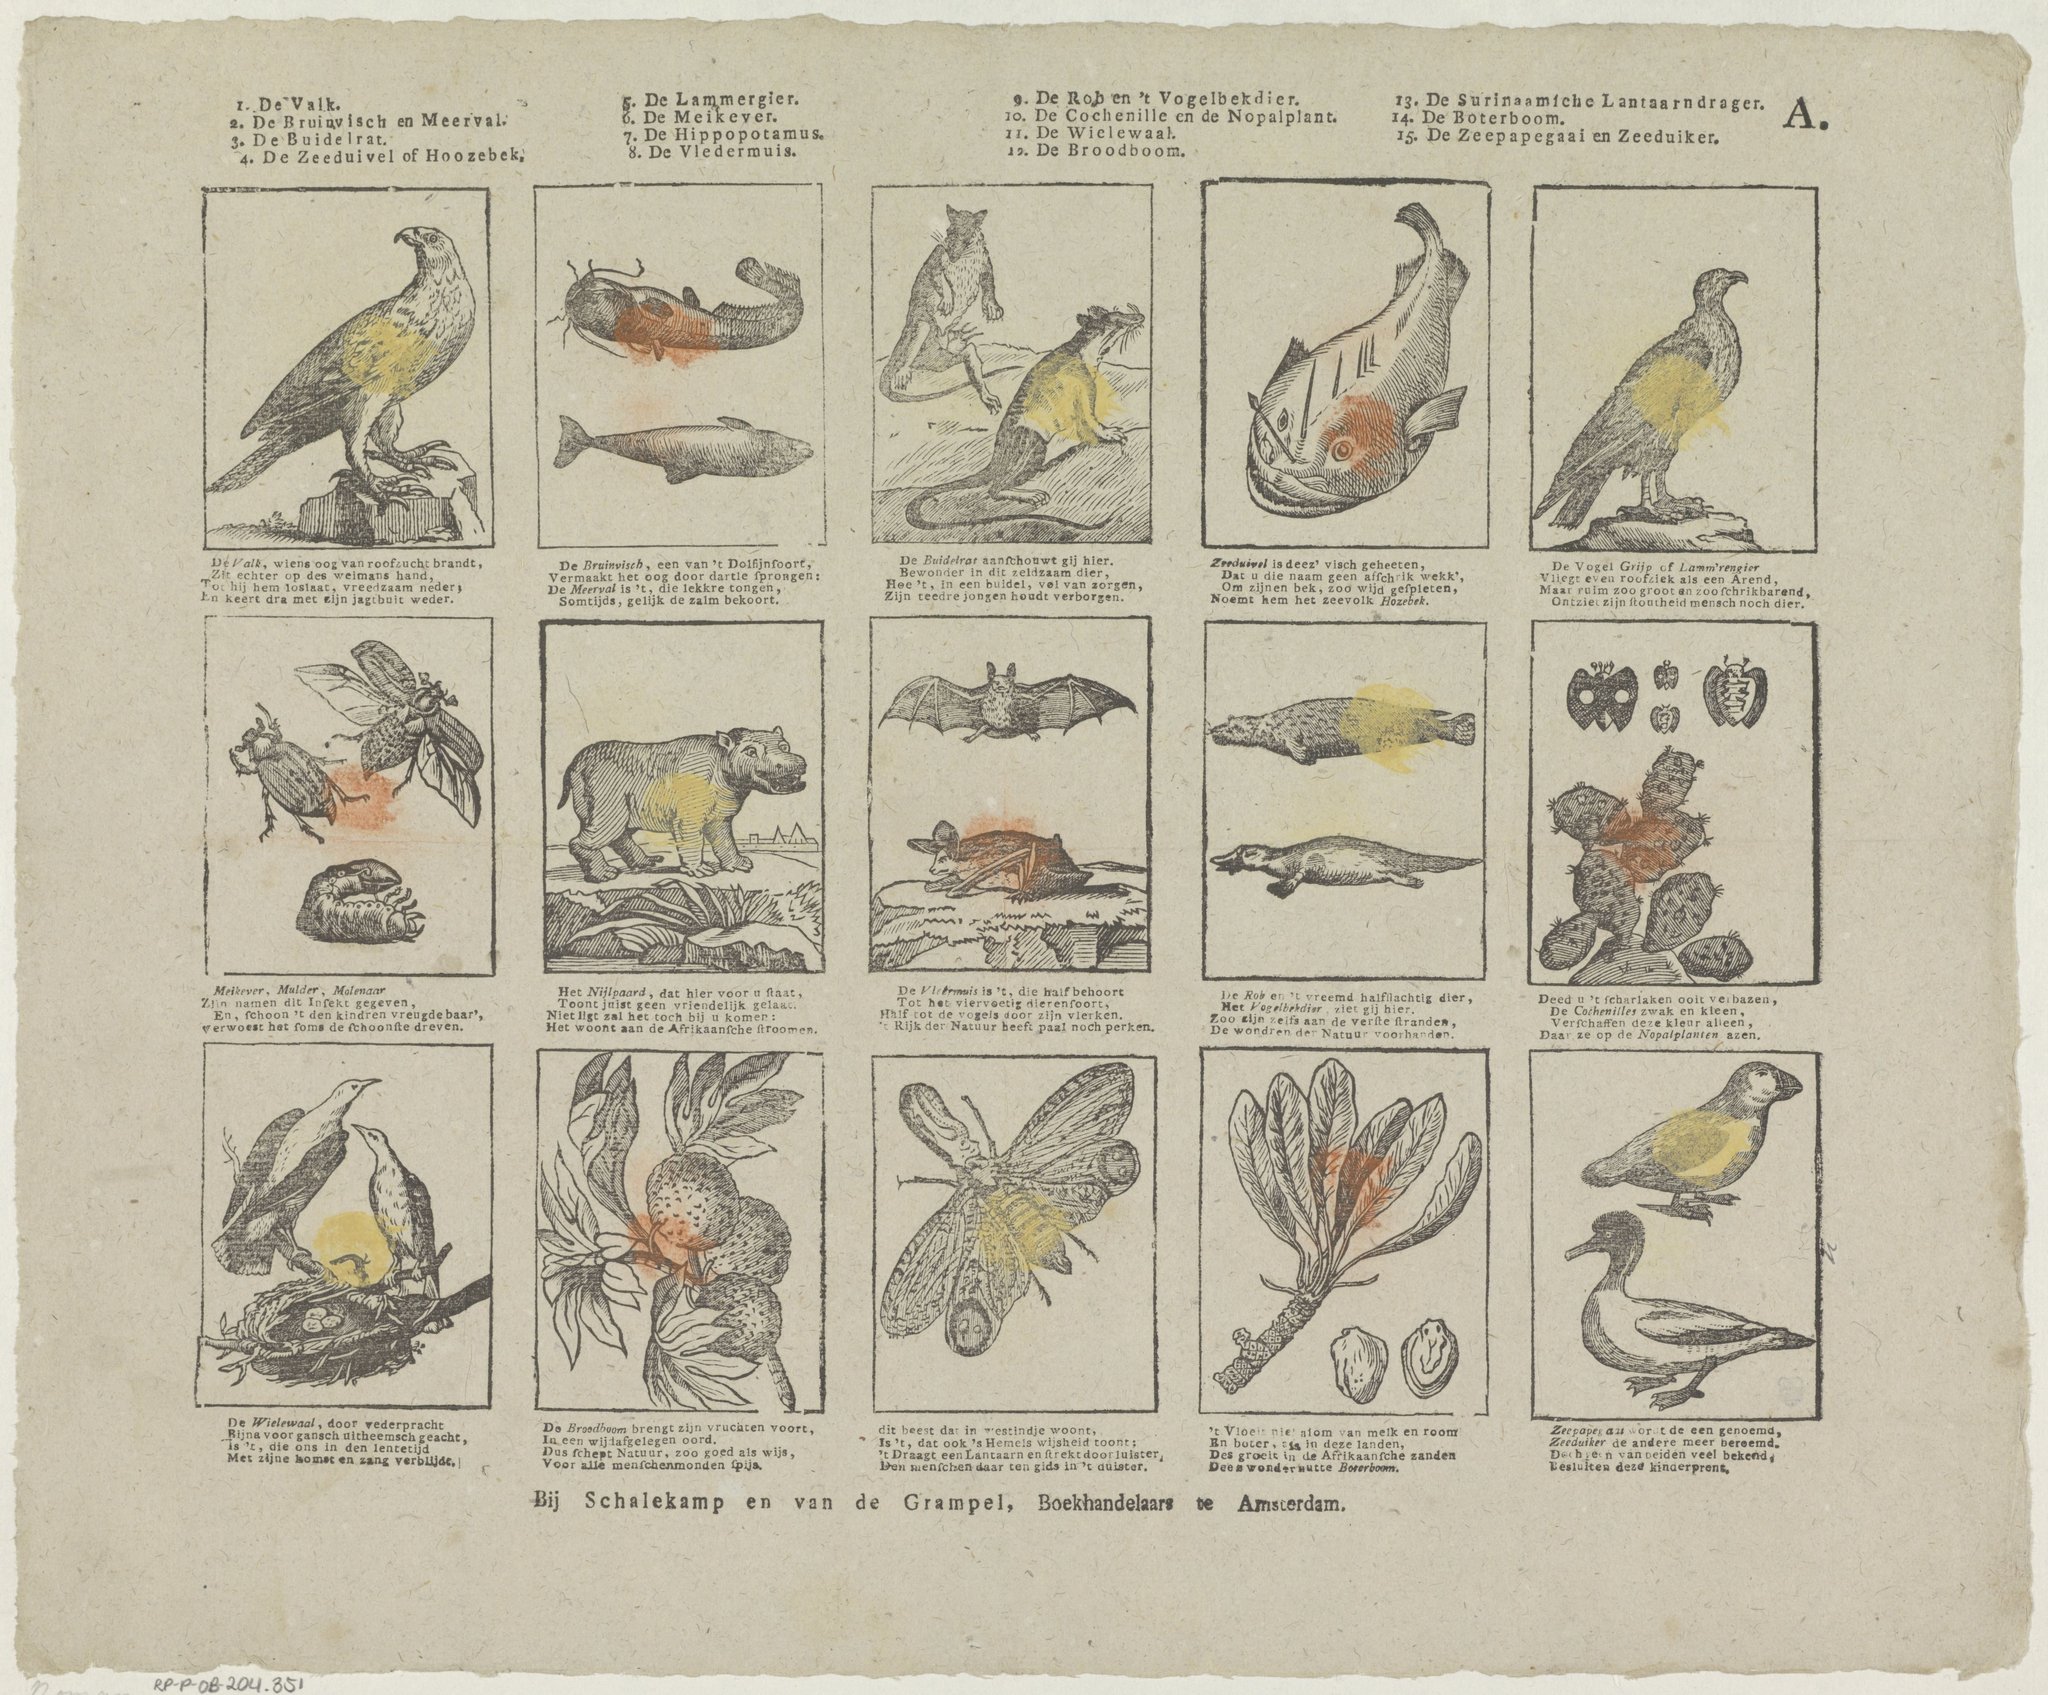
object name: popular print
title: Dieren, insecten en planten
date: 1806-1837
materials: paper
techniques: colour, letterpress printing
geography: netherlands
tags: plants; vegetation, flying mammals: bat, hoofed animals: hippopotamus, animals, birds, fishes, plants and herbs: cactus, insects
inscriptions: collector's mark: Lugt 2760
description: Blad met 15 voorstellingen van dieren, insecten en planten. Onder elke afbeelding een vierregelig vers. Boven een verklarende lijst met nummers. Gemerkt rechtsboven: A.